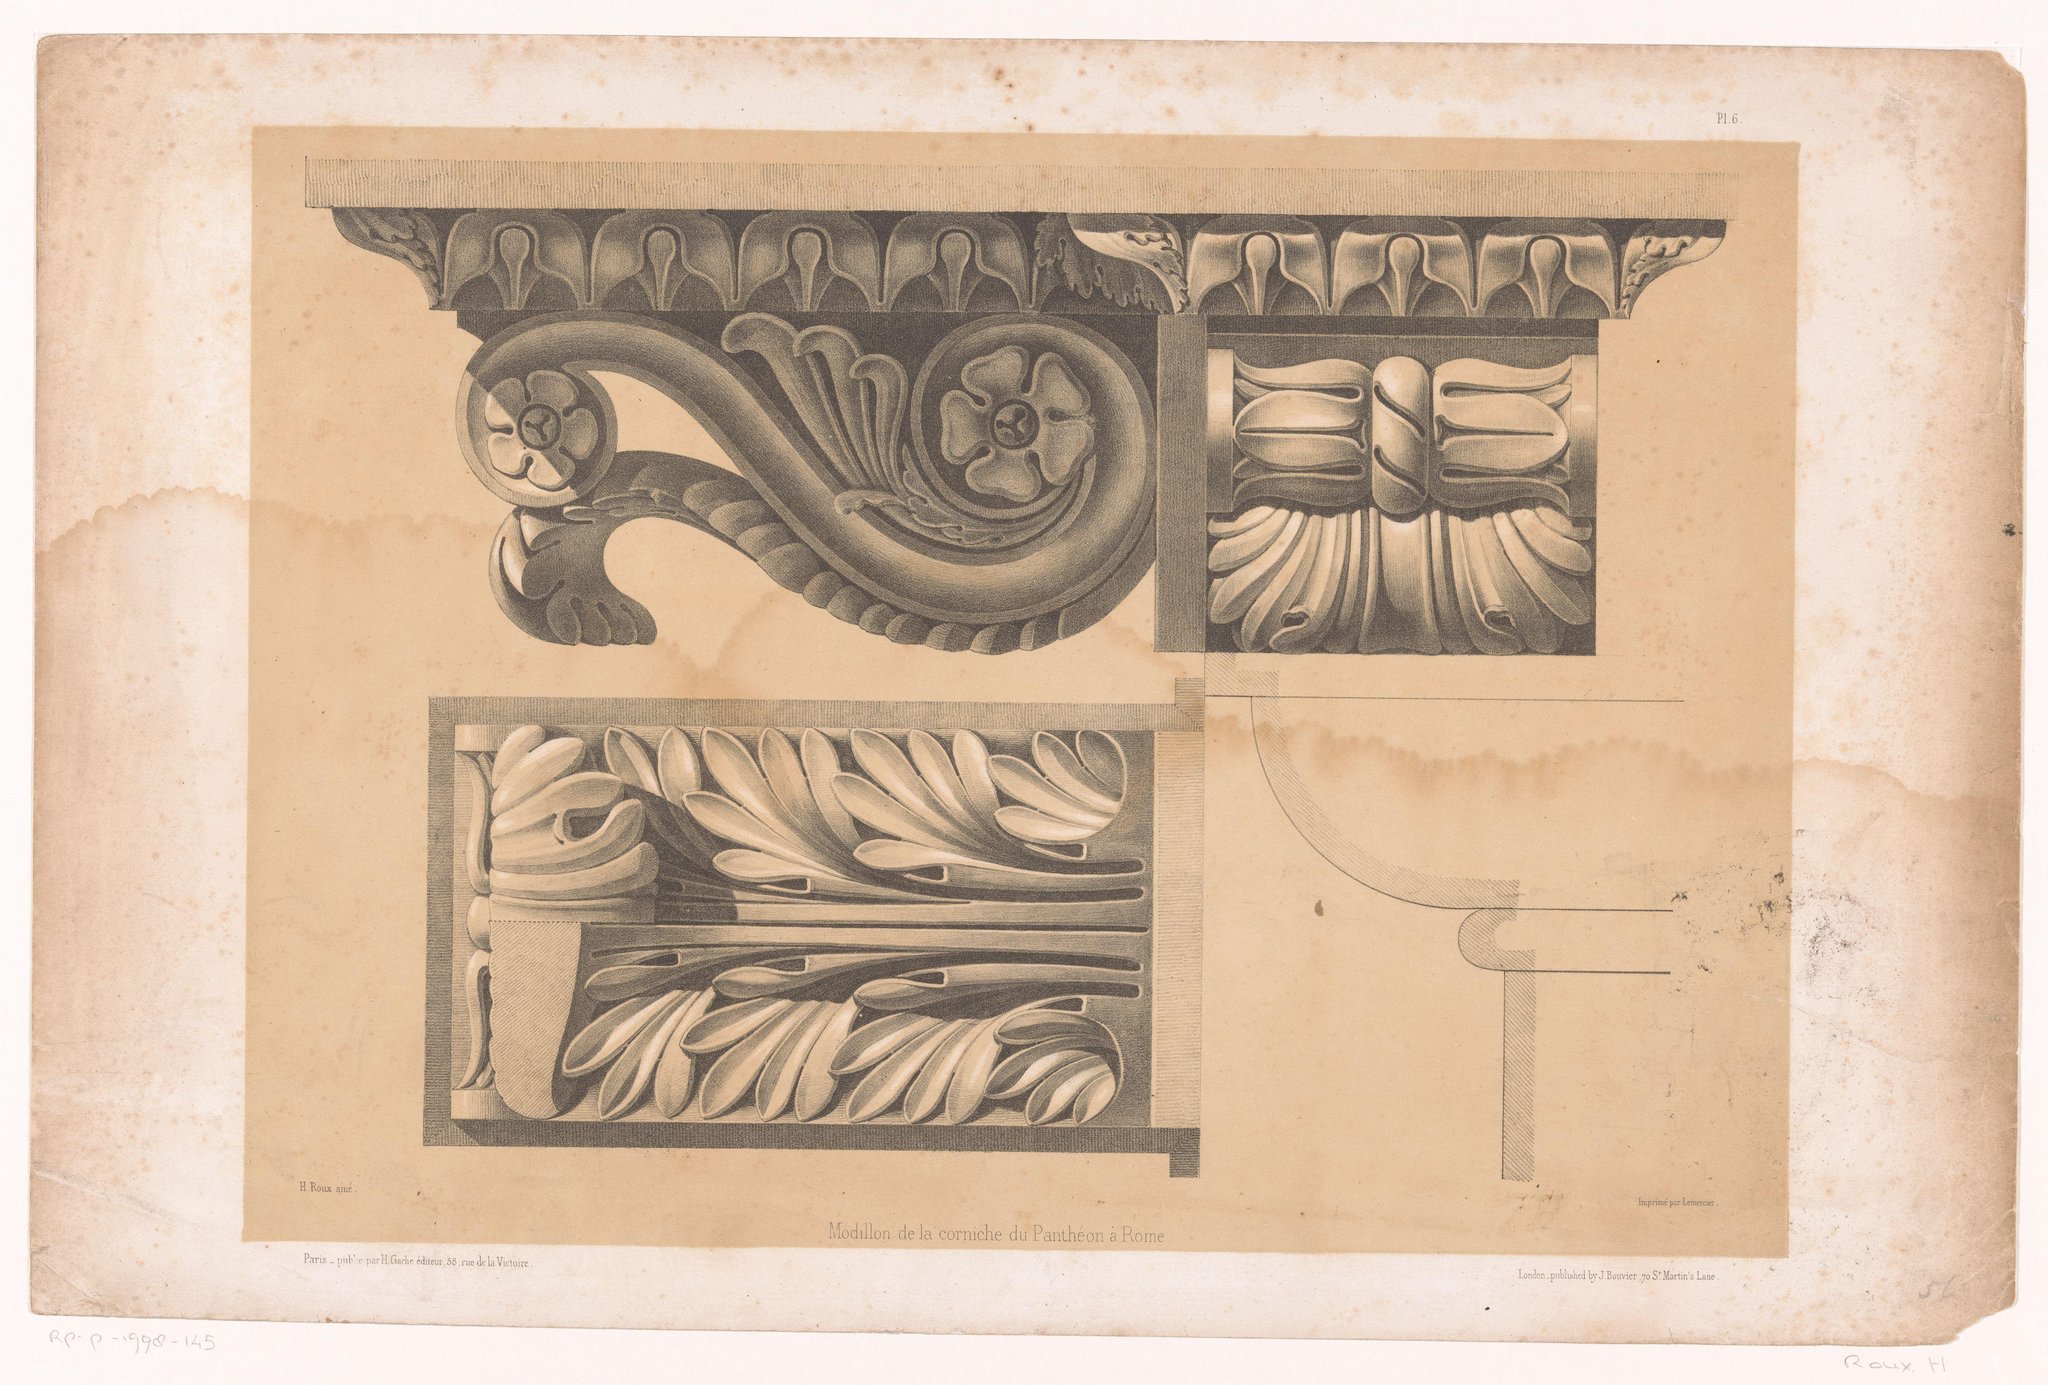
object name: print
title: Kroonlijst van Pantheon te Rome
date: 1831-1847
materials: paper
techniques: tone lithography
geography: paris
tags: other architectural details (cornice)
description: Details van de kroonlijst met acanthusbladeren van het Pantheon te Rome. Rechts boven Pl. 6 genummerd.